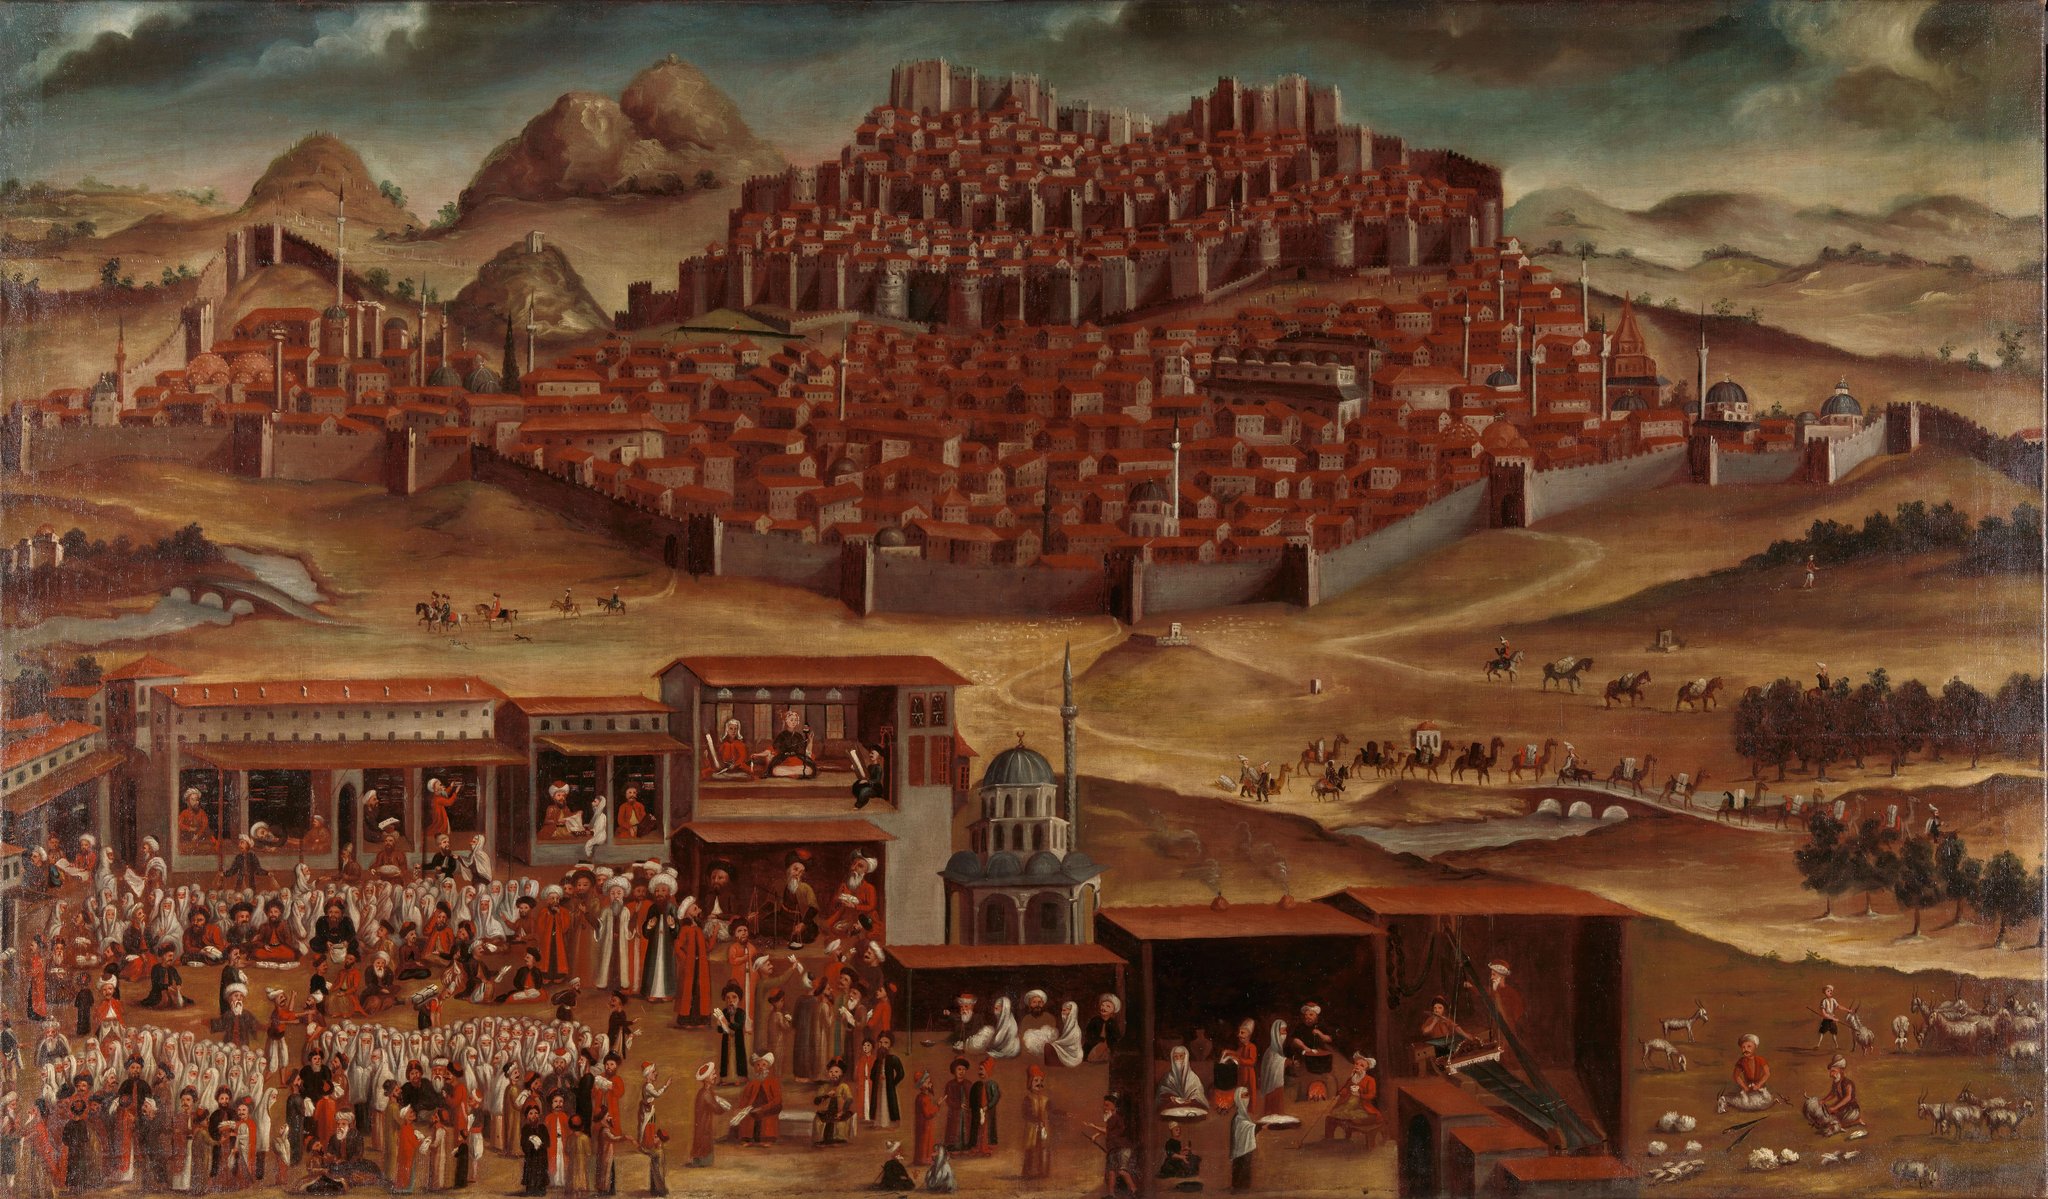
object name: painting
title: View of Ankara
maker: Anonymous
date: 1700-1799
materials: canvas, oil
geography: turkey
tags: prospect of city, town panorama, silhouette of city, wool (material ~ textile industry)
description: Op de achtergrond de ommuurde stad Ankara (Angora), op het middenplan een landschap met links mannen te paard, vergezeld door (jacht)honden en rechts een jager, een paardenkaravaan en een kamelenkaravaan die een brug oversteekt. Op de voorgrond worden de verschillende stadia van de wolproduktie getoond. Geheel rechts worden de angora geiten geschoren. Vervolgens zien we van rechts naar links het weven van de wol door een drapenier, het wassen en koken van de wol, het wegen van de wol, het nogmaals wegen (mogelijk de keuring van de wol), het spinnen en de verkoop van de wol en een druk bezochte marktplaats.